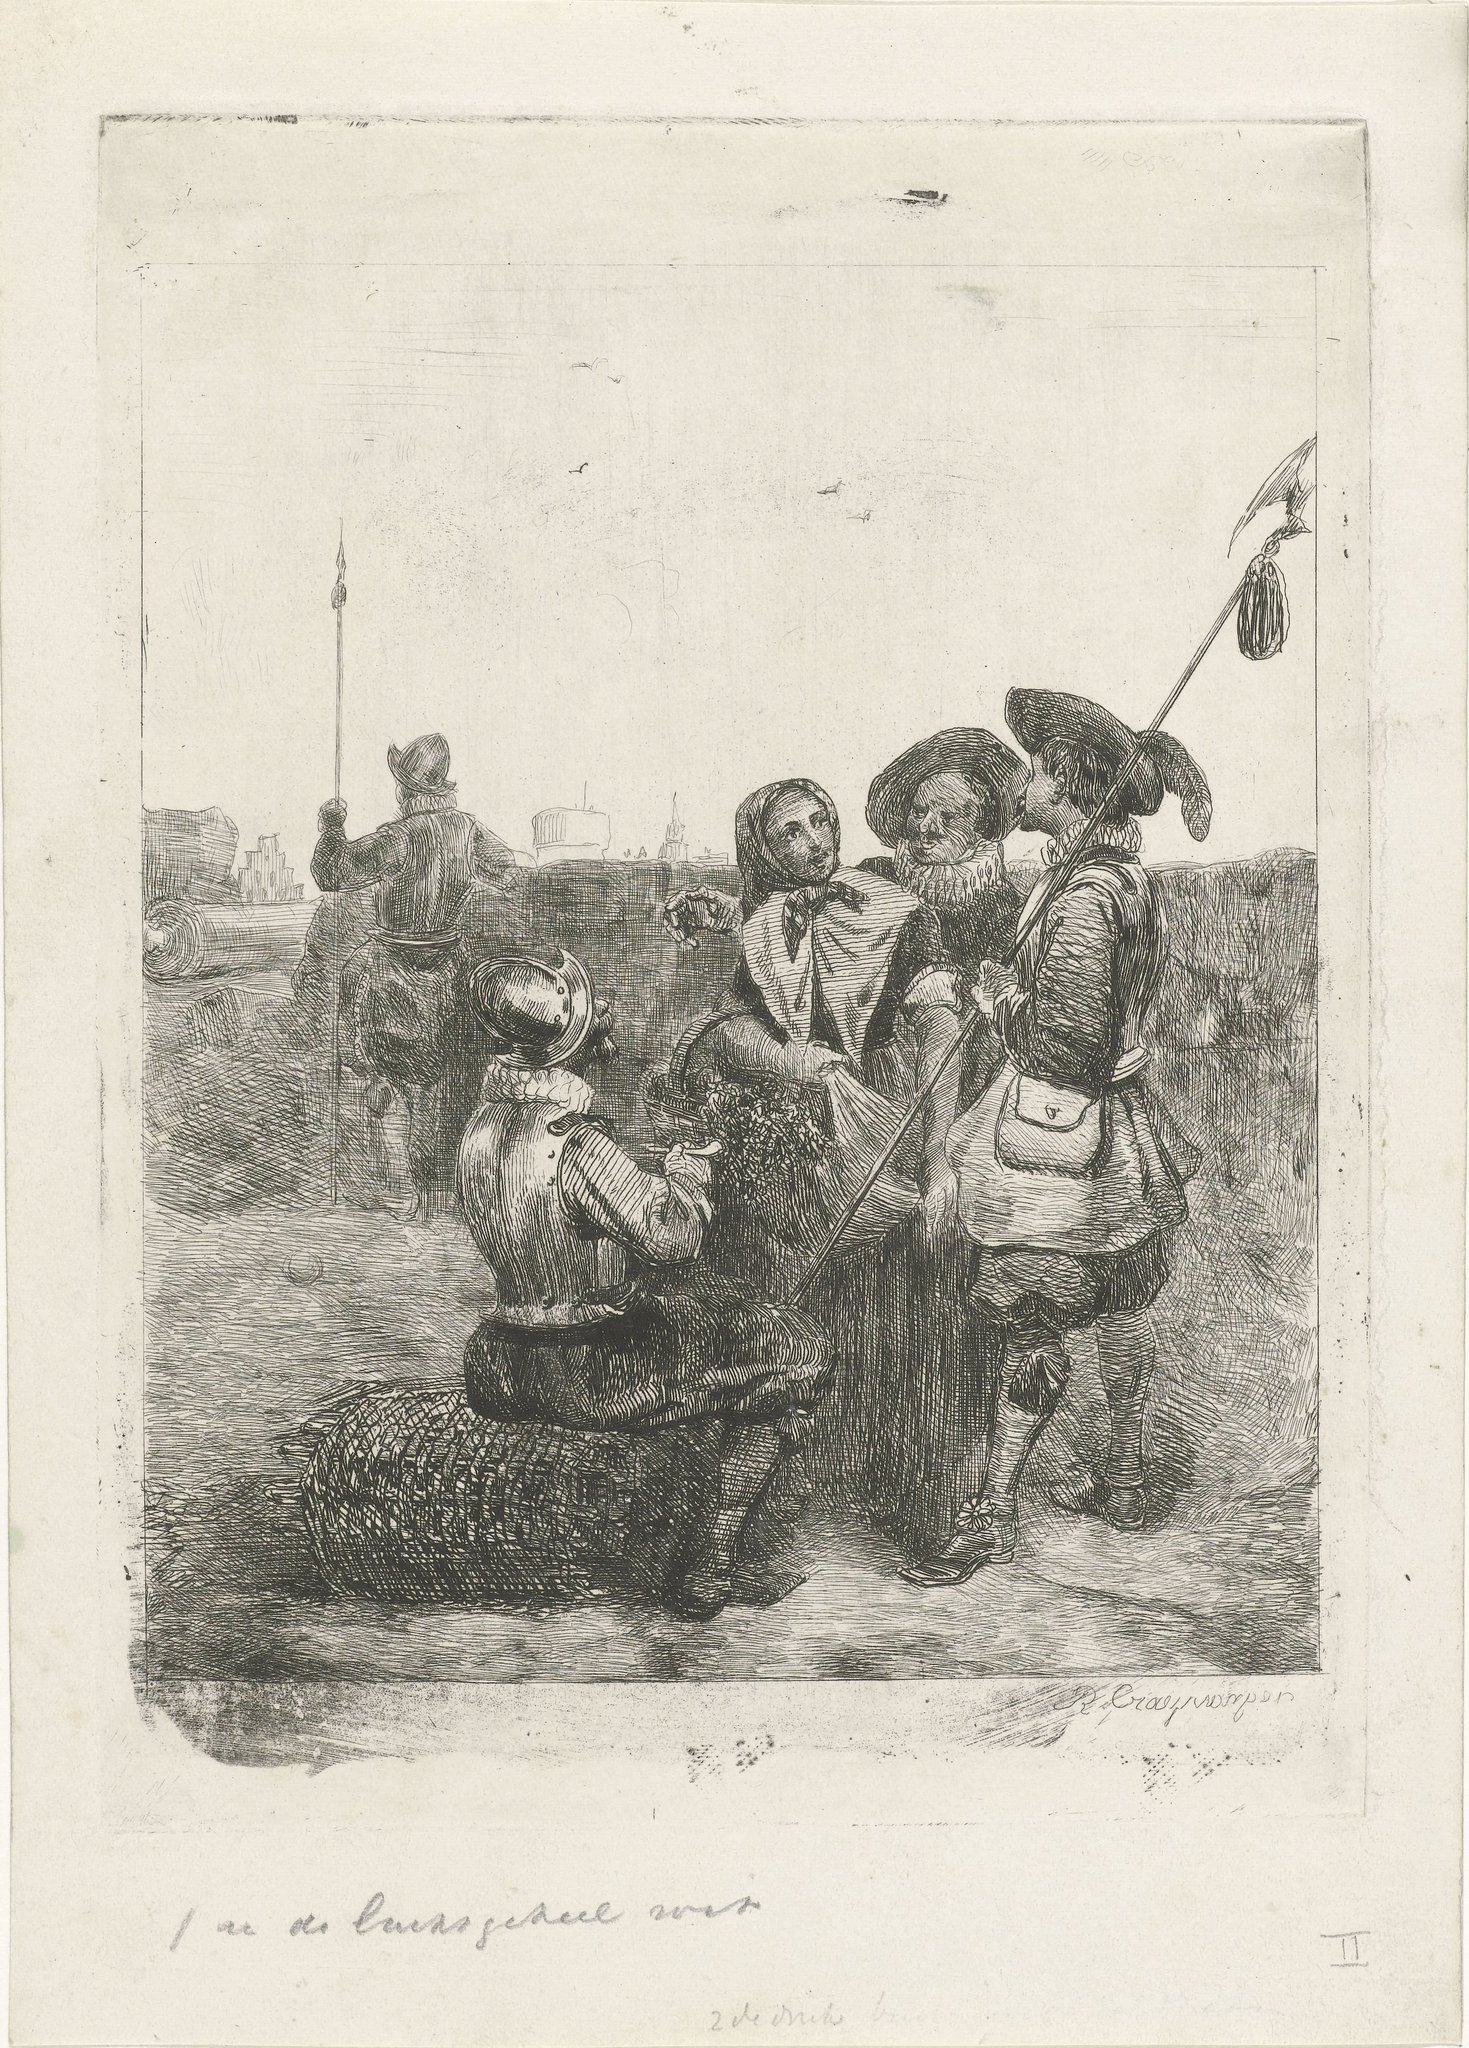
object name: print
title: Soldaten met een jong meisje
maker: reinier craeyvanger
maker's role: draughtsman, print maker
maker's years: 1812-1880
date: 1822-1880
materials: paper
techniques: etching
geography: amsterdam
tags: fortifications, military engineering, firearms: cannon, the soldier; the soldier's life, women camp-followers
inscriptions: collector's mark: Lugt 2228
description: Bovenop een versterking van een stad wordt een jong meisje omringd door drie soldaten. Een van de soldaten zit op een mand en rookt pijp. Op de achtergrond een kanon.